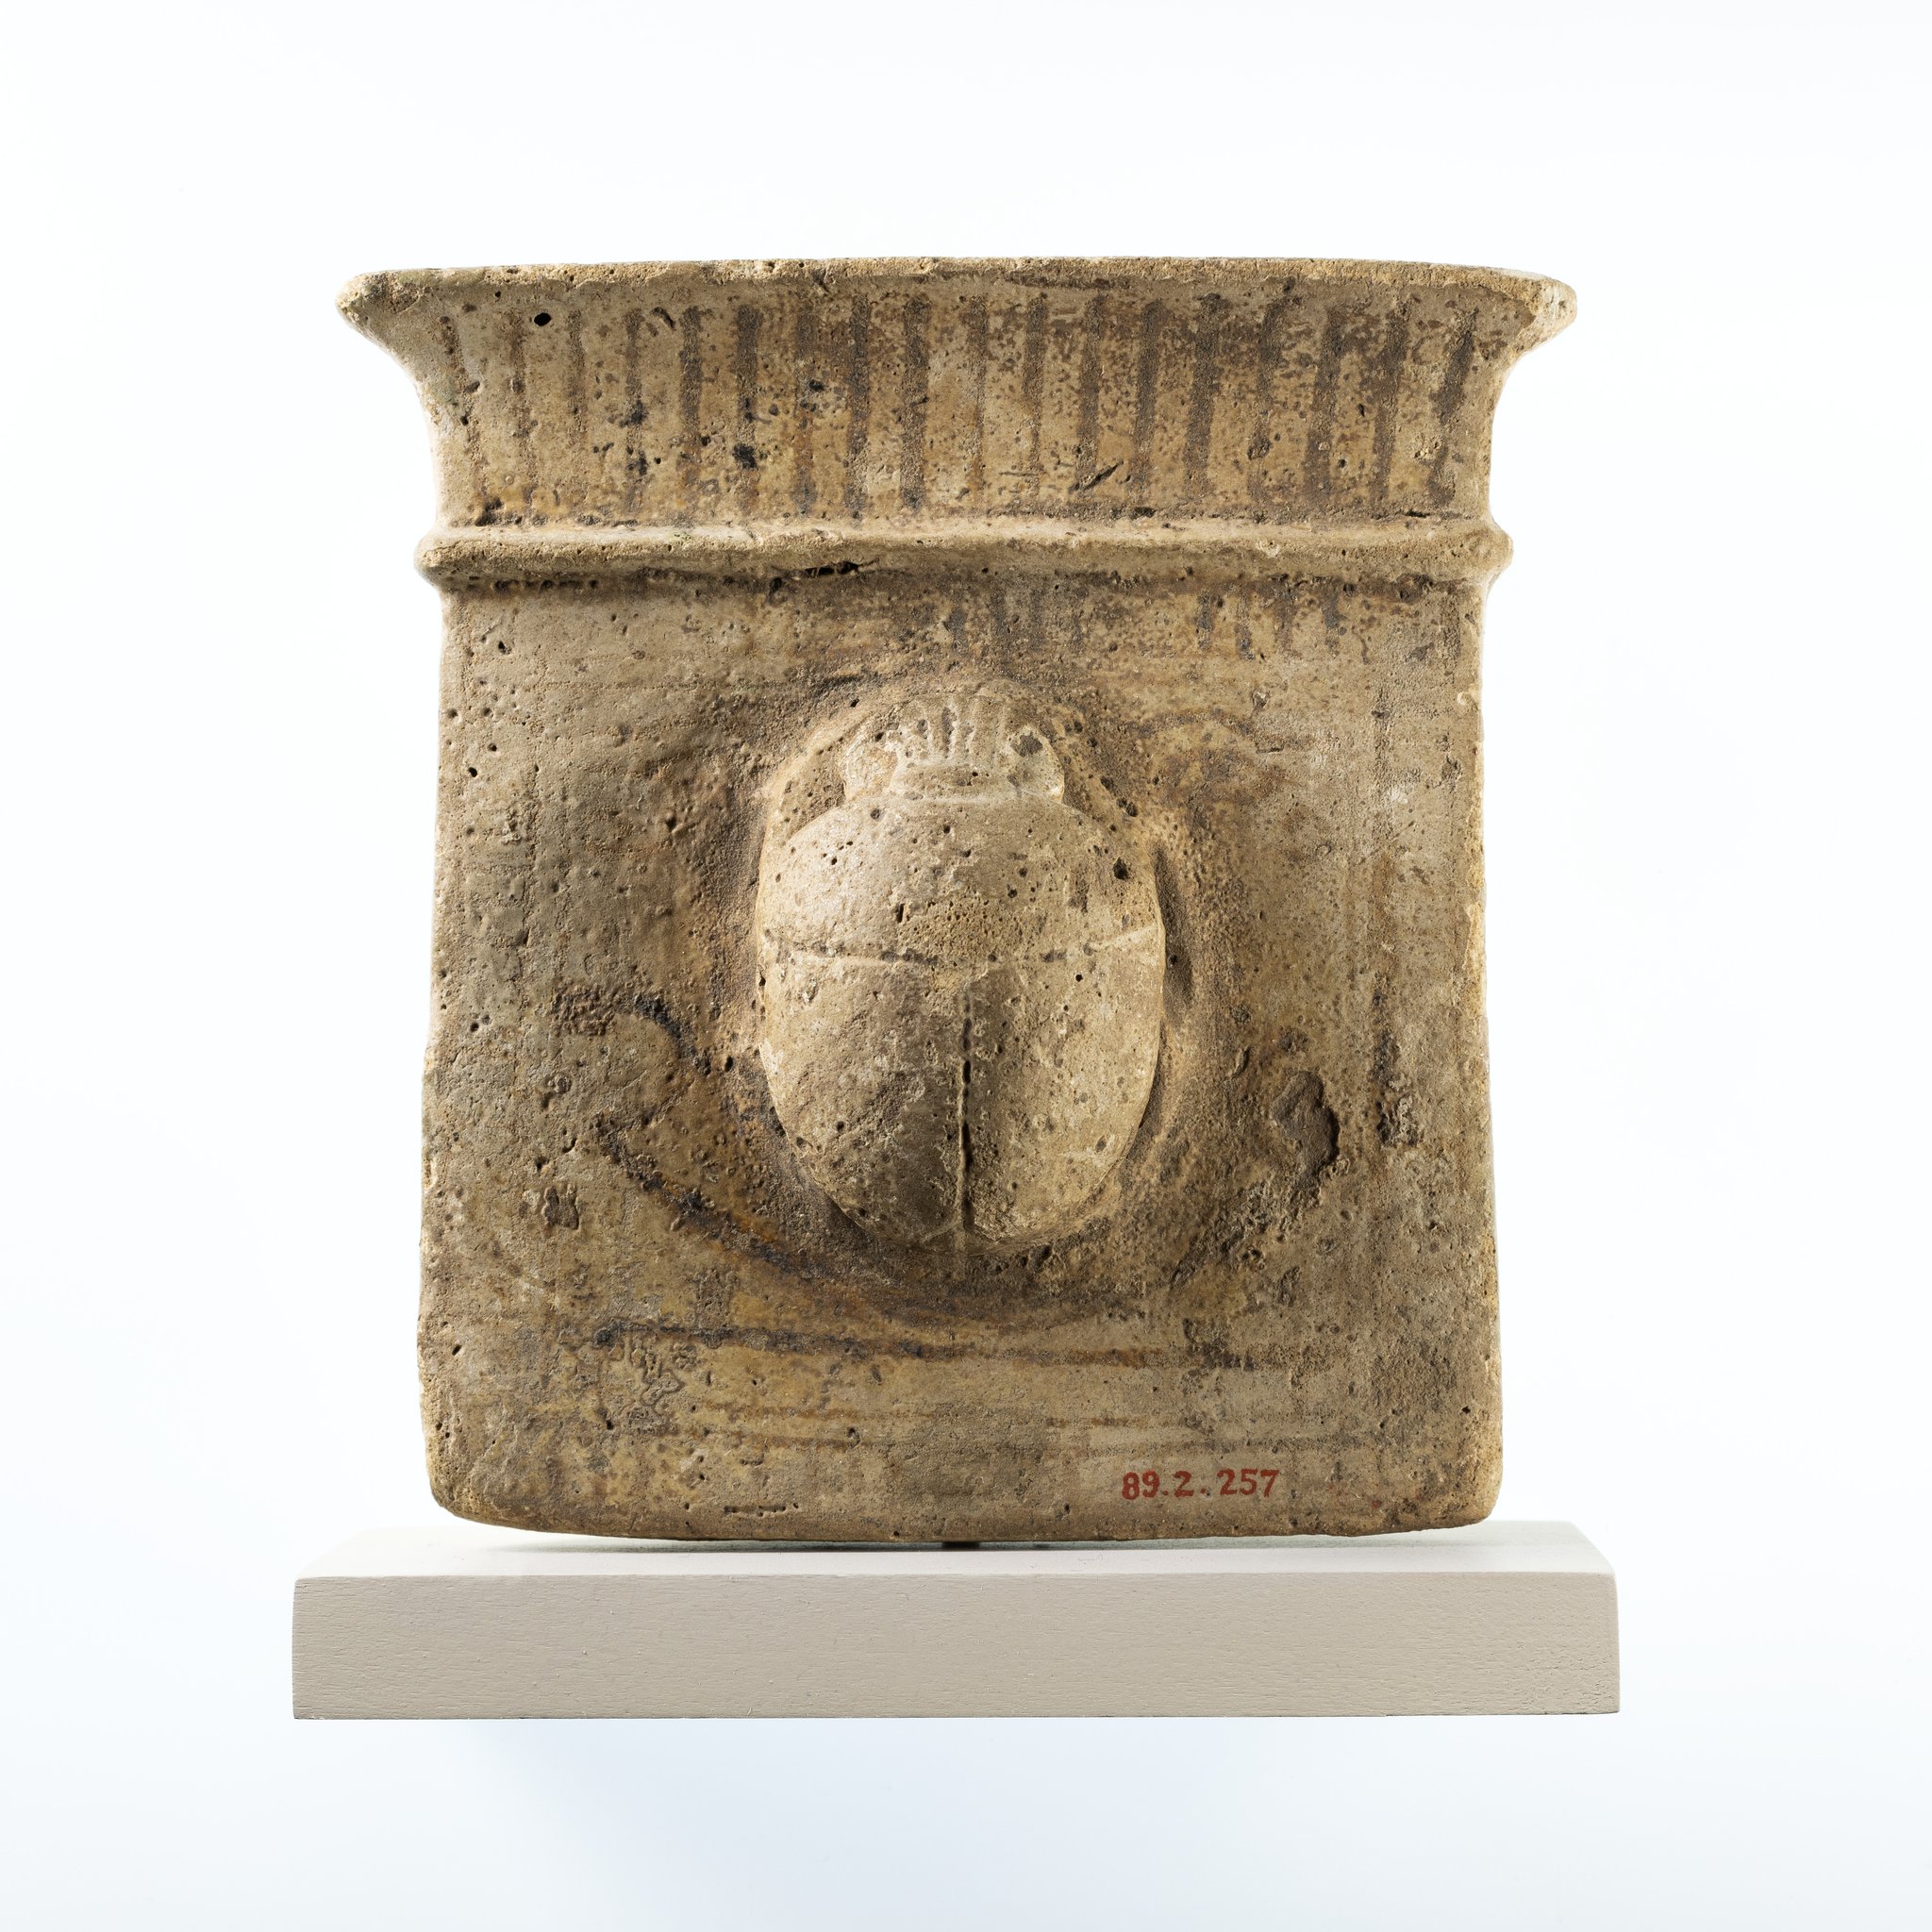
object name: pectoral with scarab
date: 1070-525 BCE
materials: faience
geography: egypt